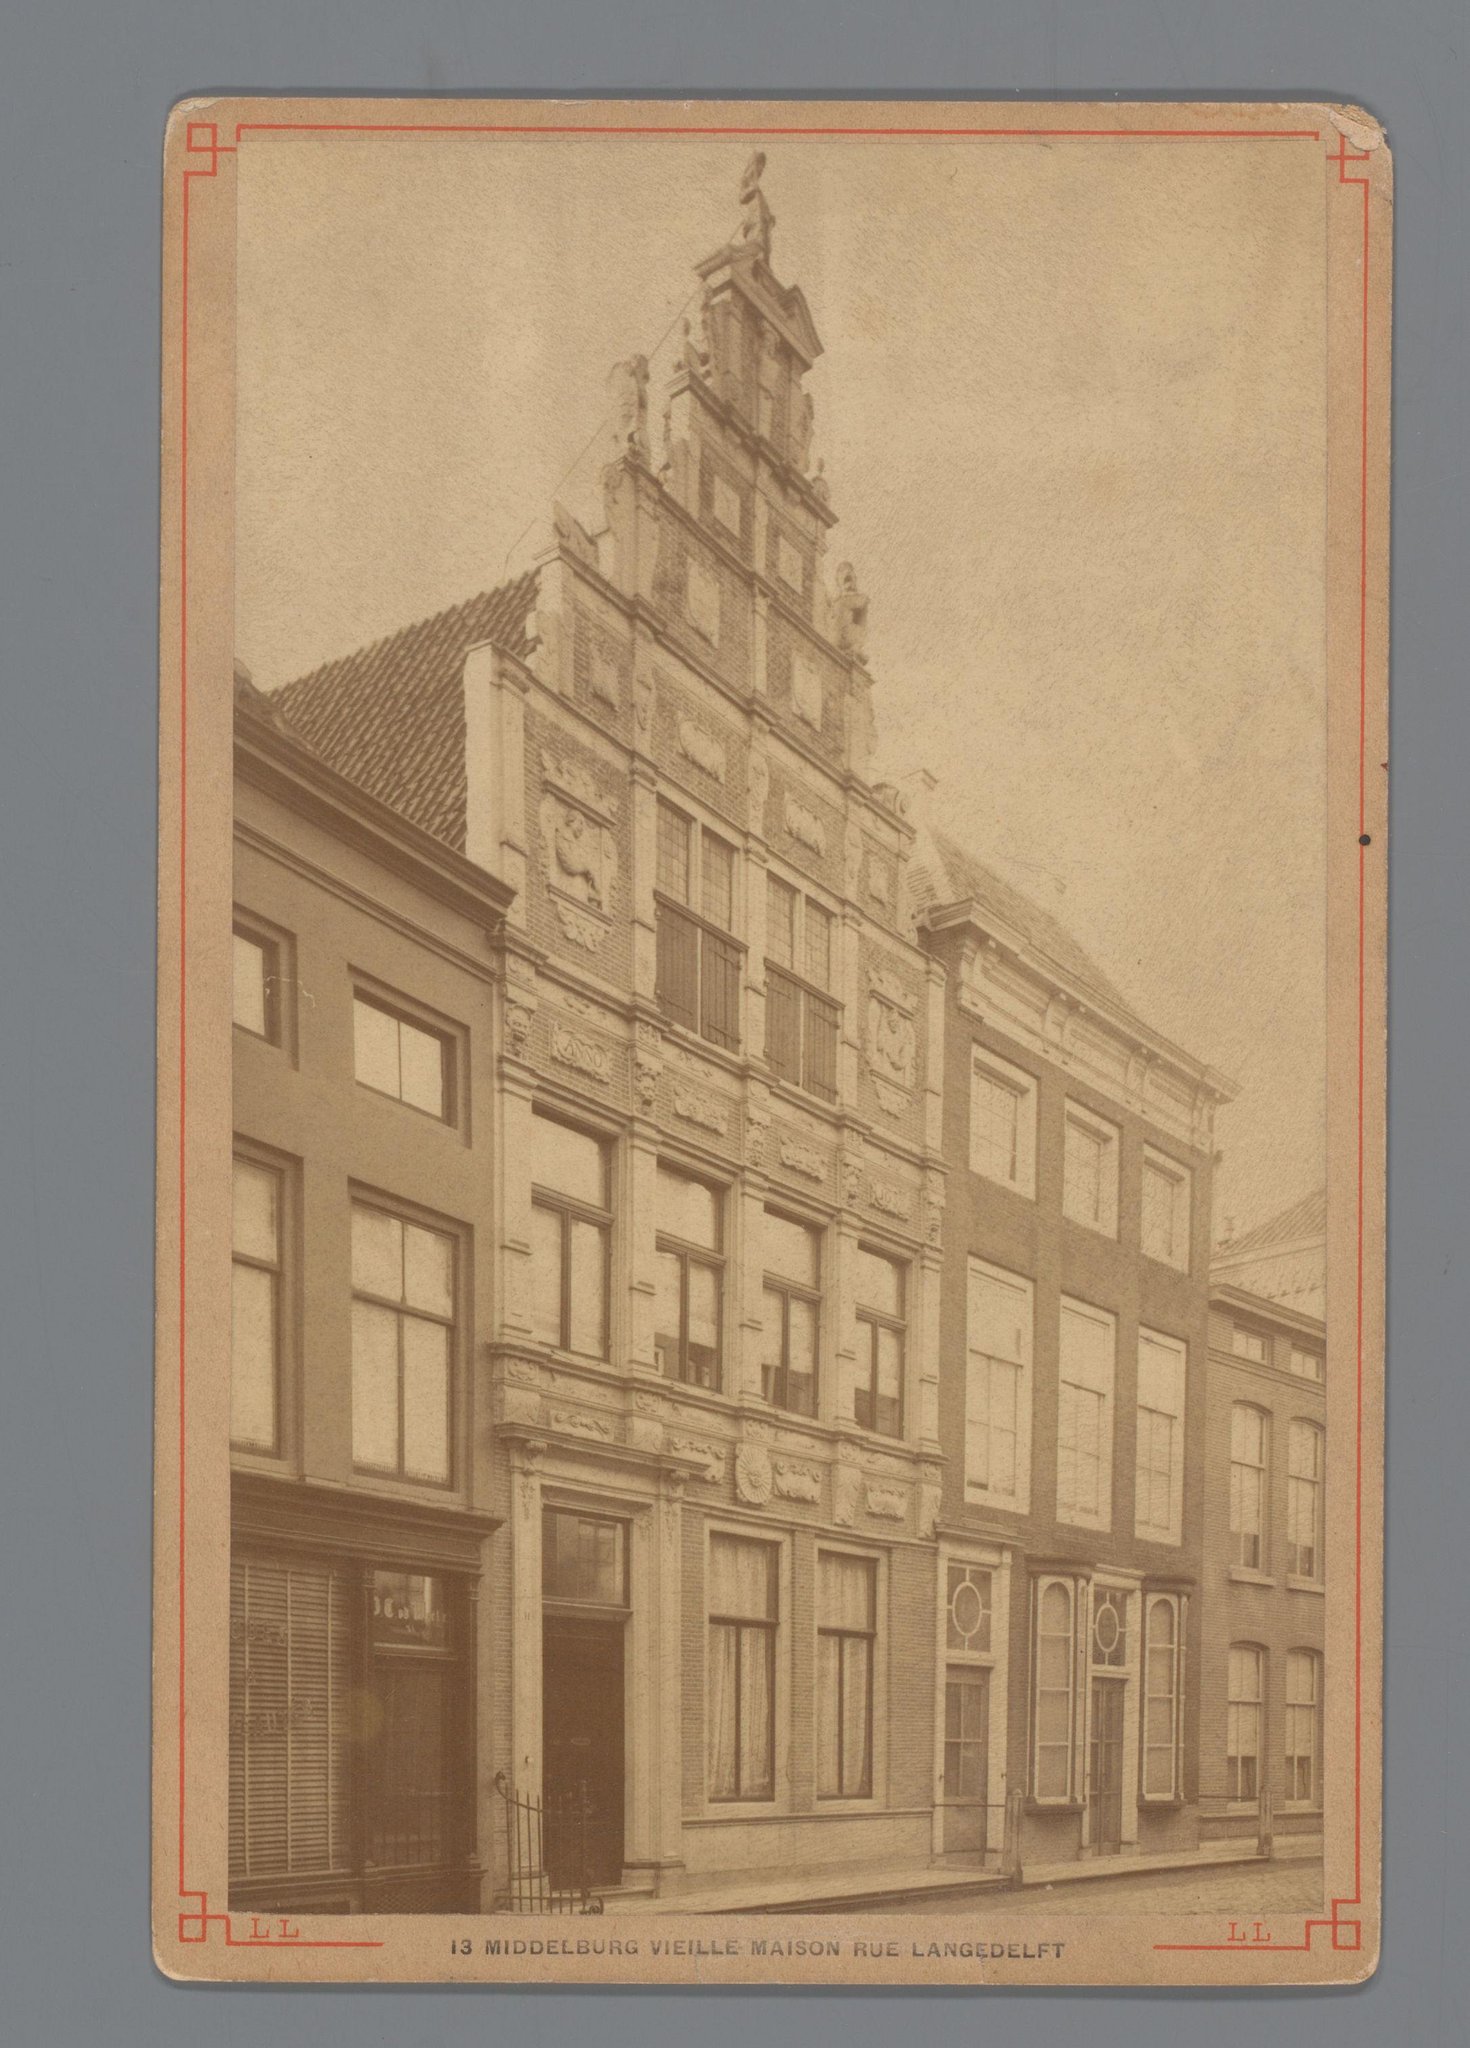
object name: cabinet photograph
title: Gevel van de Gouden Zon in de Lange Delft te Middelburg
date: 1870-1900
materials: cardboard, photographic support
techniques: albumen print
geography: middelburg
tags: façade (of house or building), middelburg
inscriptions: annotation: ‘Huis de zon’, inscription: ‘LL/ 13 Middelbur vieille maison rue Langedelft’